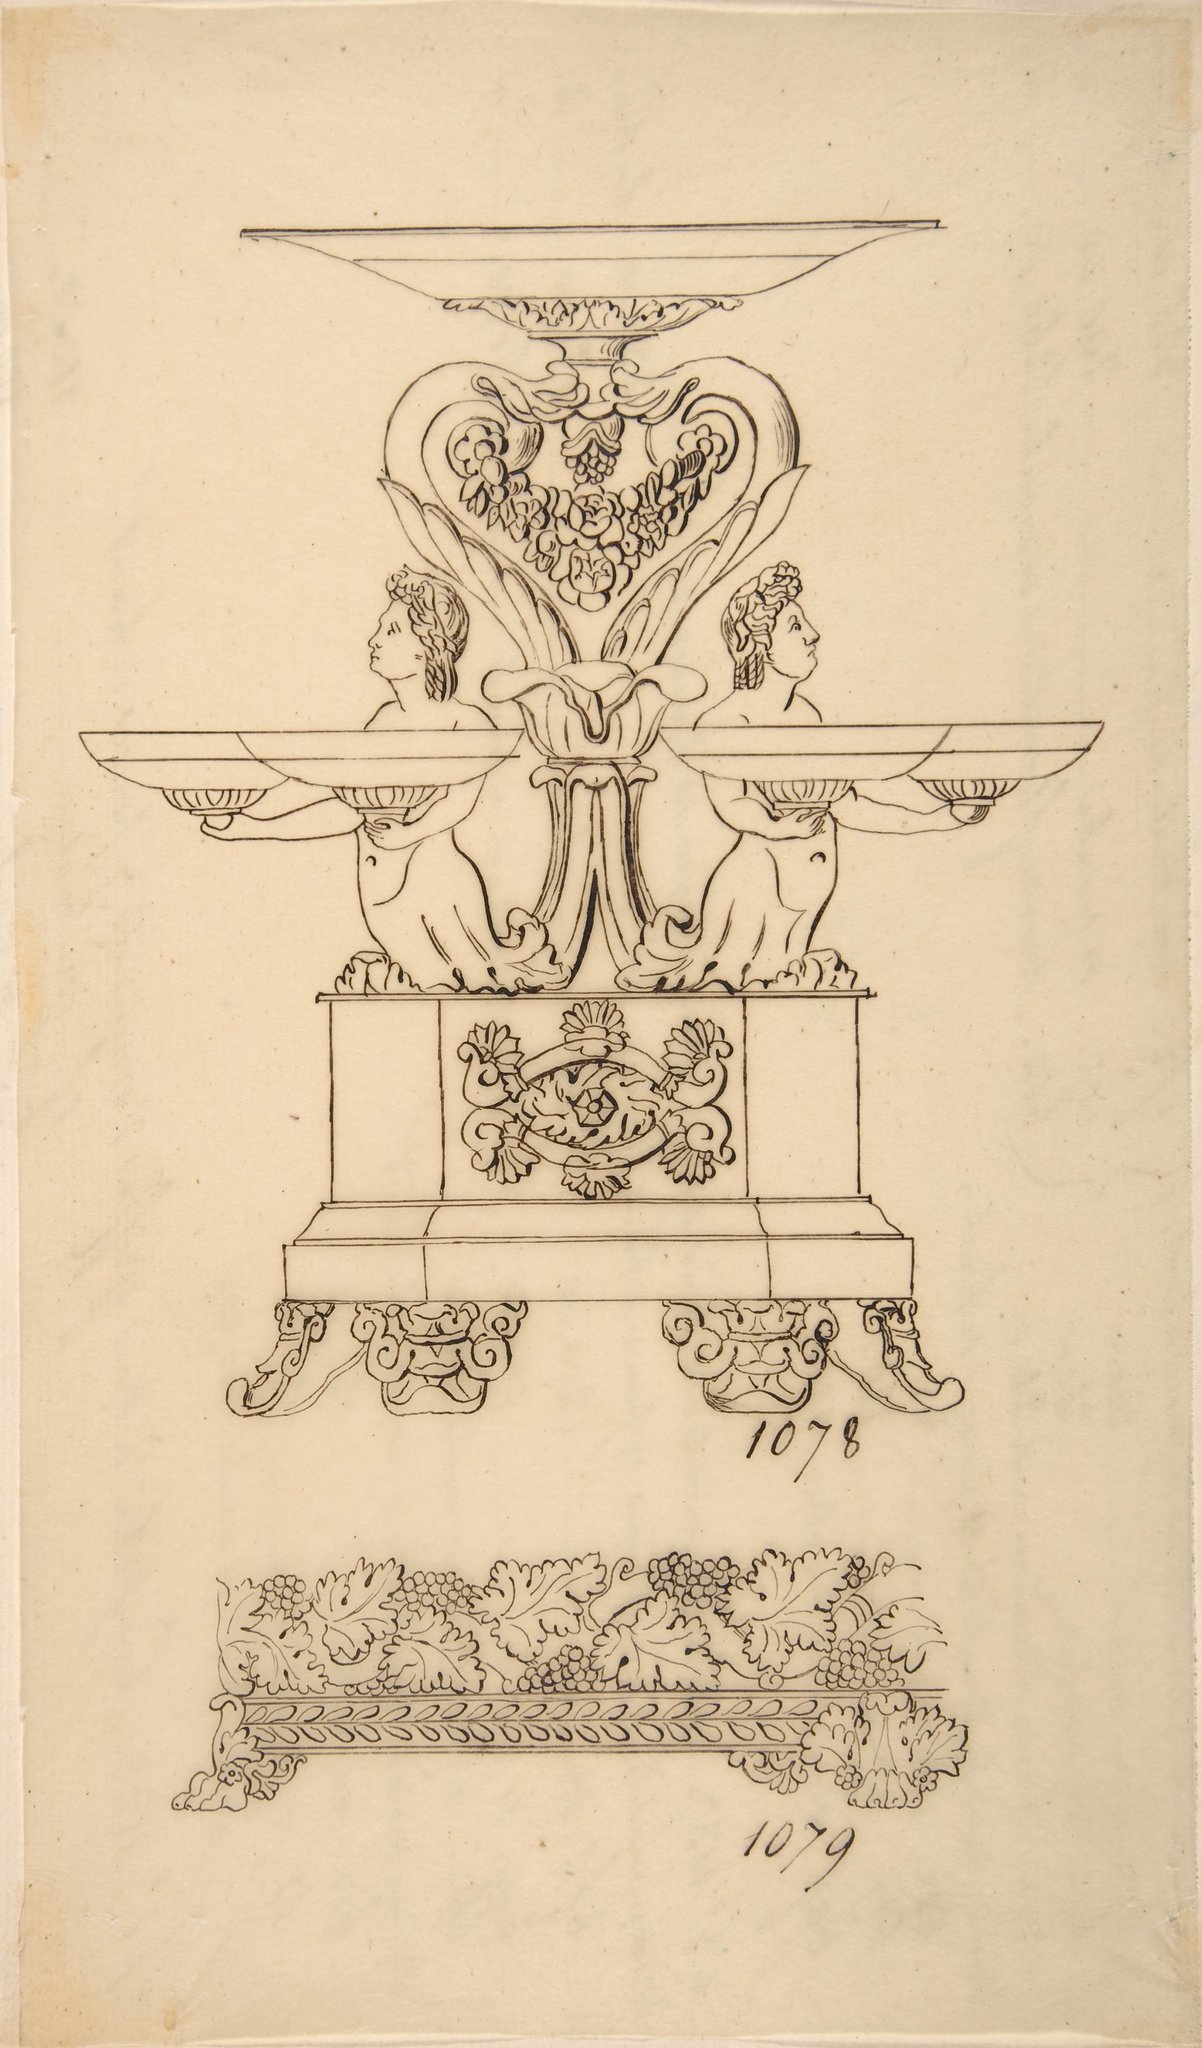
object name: drawing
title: Design for a Candelabra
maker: anonymous, french, 19th century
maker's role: artist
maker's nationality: french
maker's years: 1800-1900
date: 1801-1900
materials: ink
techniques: pen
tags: candelabra